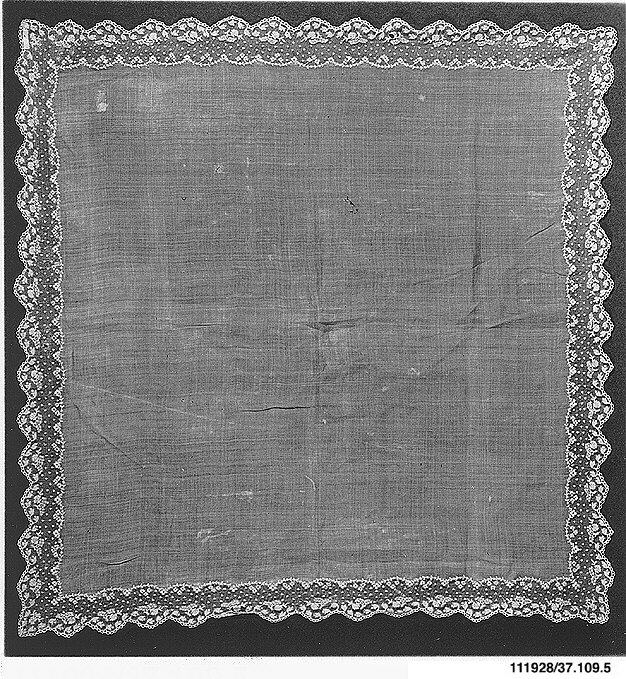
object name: kerchief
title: Kerchief (Pañuelo)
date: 1801-1850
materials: fiber